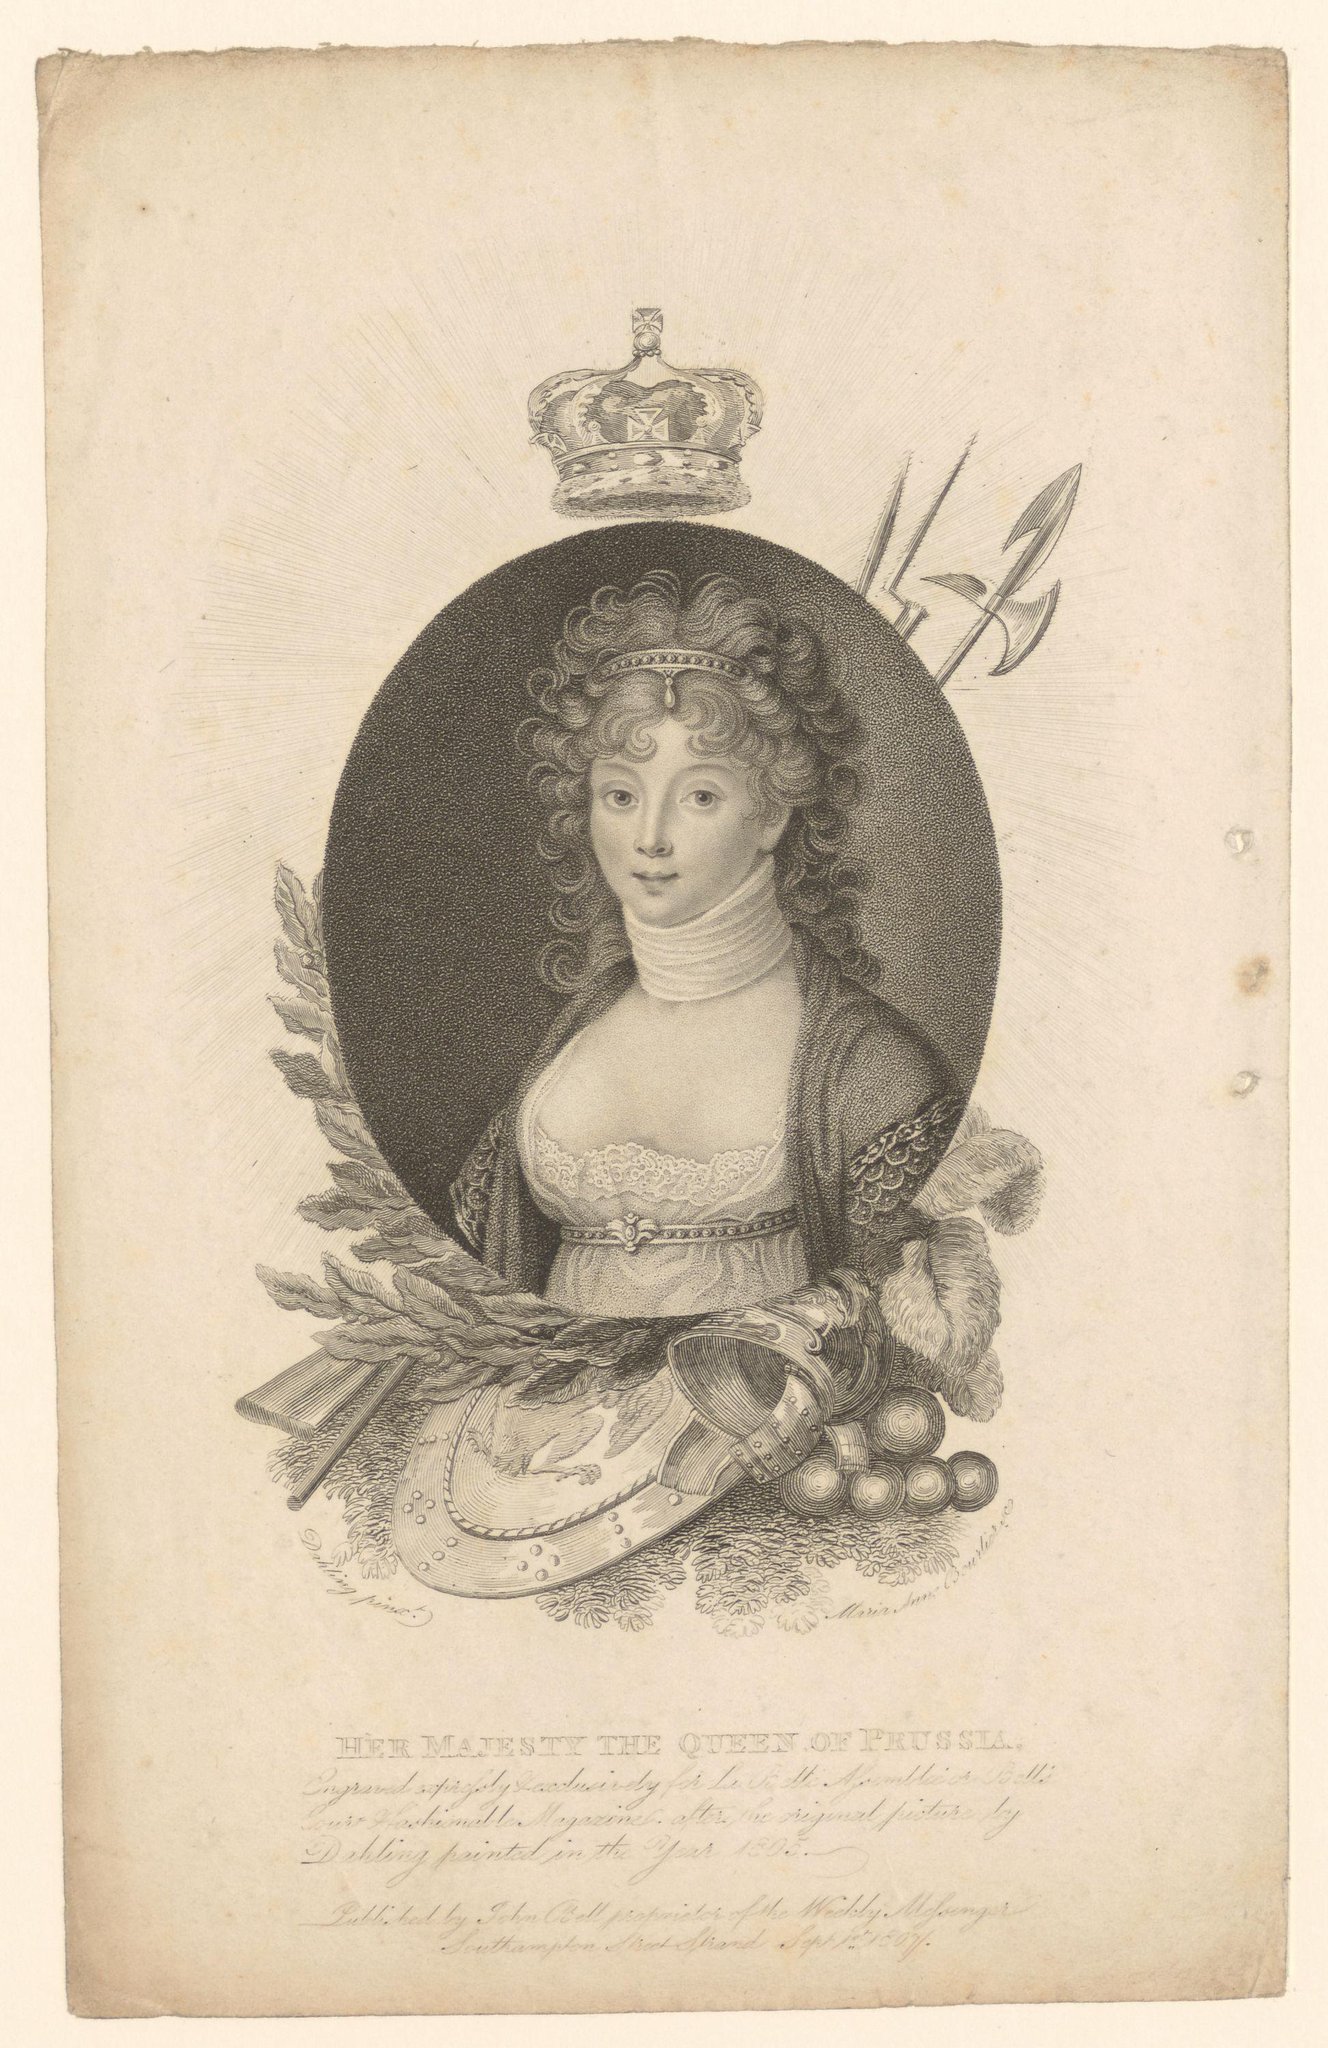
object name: print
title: Portret van Louise van Mecklenburg-Strelitz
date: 1807-1809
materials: paper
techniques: etching, engraving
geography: london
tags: historical persons, queen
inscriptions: collector's mark: Lugt 2228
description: Prent uit: La Belle Assemblée: or Bell's Court and fashionable Magazine, 1807.